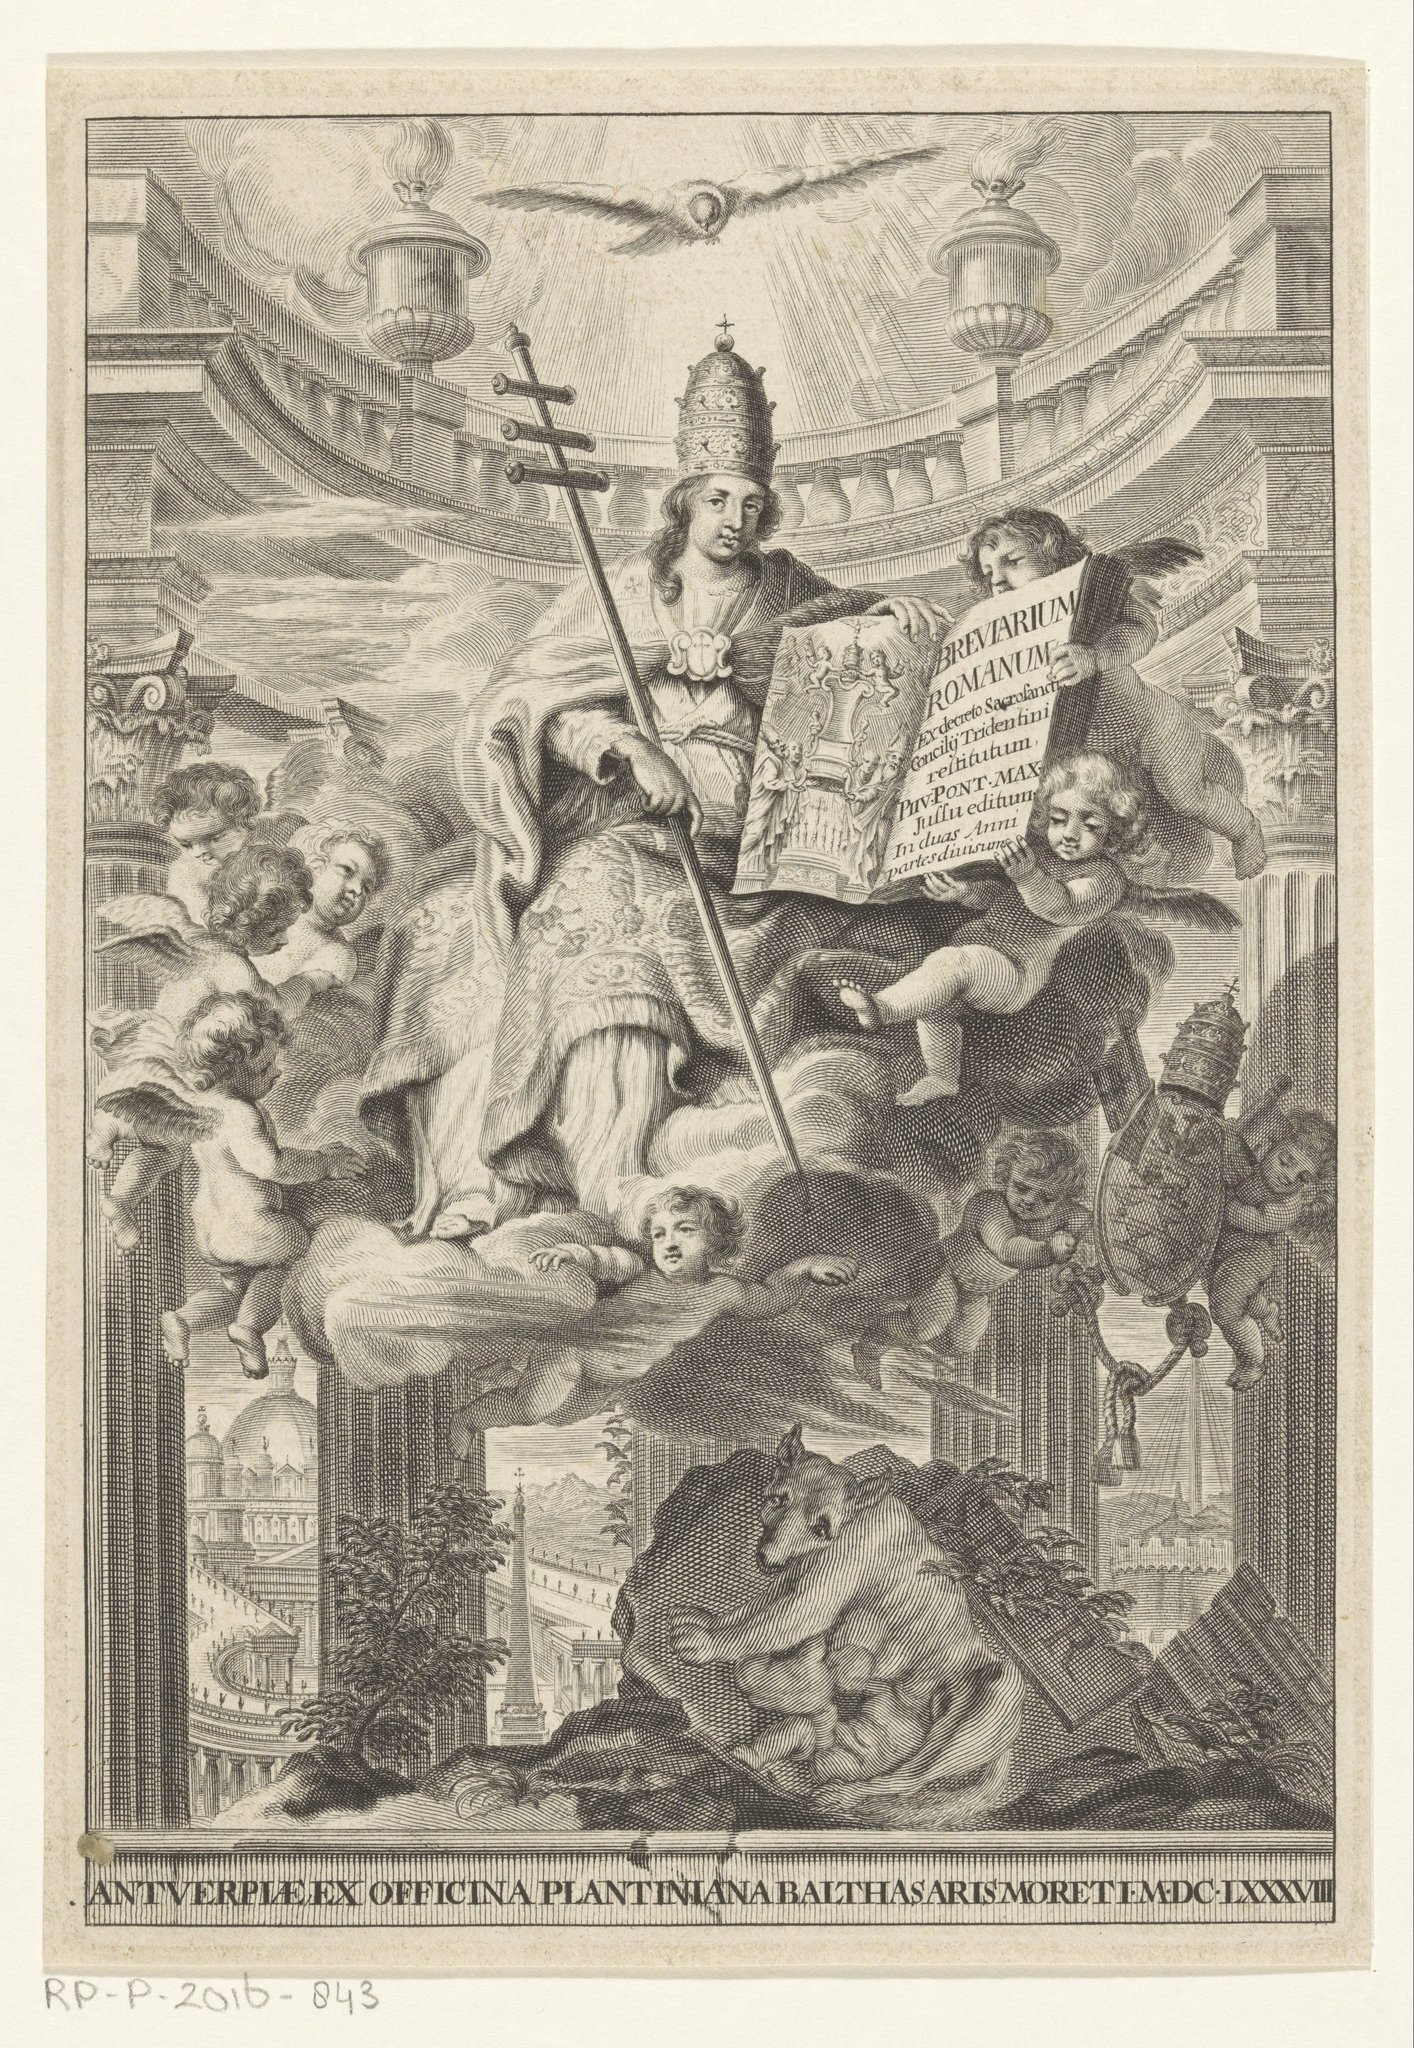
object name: titelblad, titelpagina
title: Titelpagina voor: S.n., Breviarium romanum, 1688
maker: martin bouche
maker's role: print maker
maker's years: 1640-1693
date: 1688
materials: paper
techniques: engraving, etching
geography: antwerp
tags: triumph of the church (or religion), insignia of the pope, e.g. tiara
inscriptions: collector's mark: Lugt 2228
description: De personificatie van de Rooms-katholieke kerk met bisschopsstaf, pauselijke tiara en een boek met altaar en de titel van het boek, omgeven door putti. Boven haar een duif als symbool van de heilige geest. Rechts twee putti met een pauselijk wapenschild. Aan de onderzijde Romulus en Remus en de wolvin.